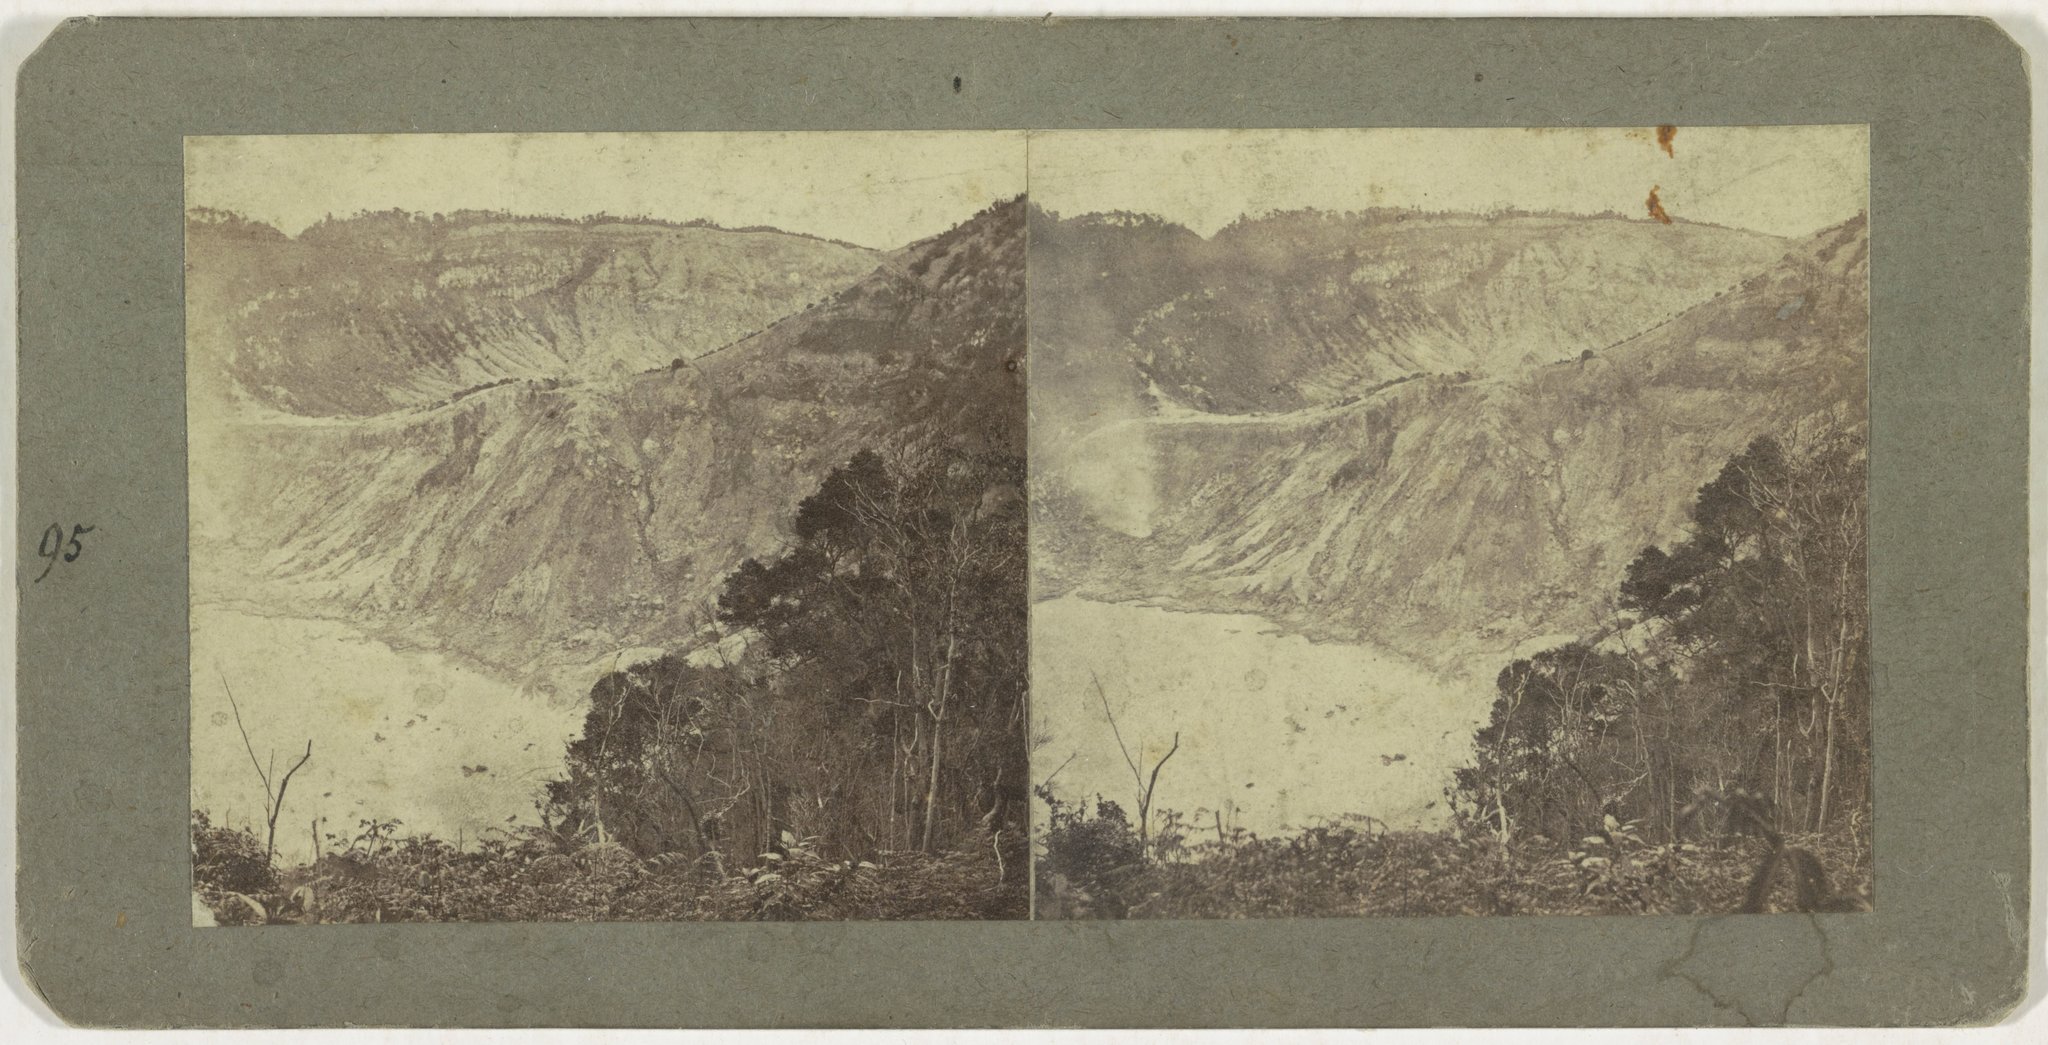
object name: stereograph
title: Gezicht op vermoedelijk de Kawah Ratu krater op de Tangkuban Perahu, West-Java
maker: Anonymous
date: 1868-1890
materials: cardboard, paper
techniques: albumen print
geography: tangkuban perahu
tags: volcano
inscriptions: inscription: ‘Westelijke Krater, Kawah oepas,/ van den Goen. Tang Koeban Praauw/ de voorgrond 6300 voet./ 1.’, number: ‘95’